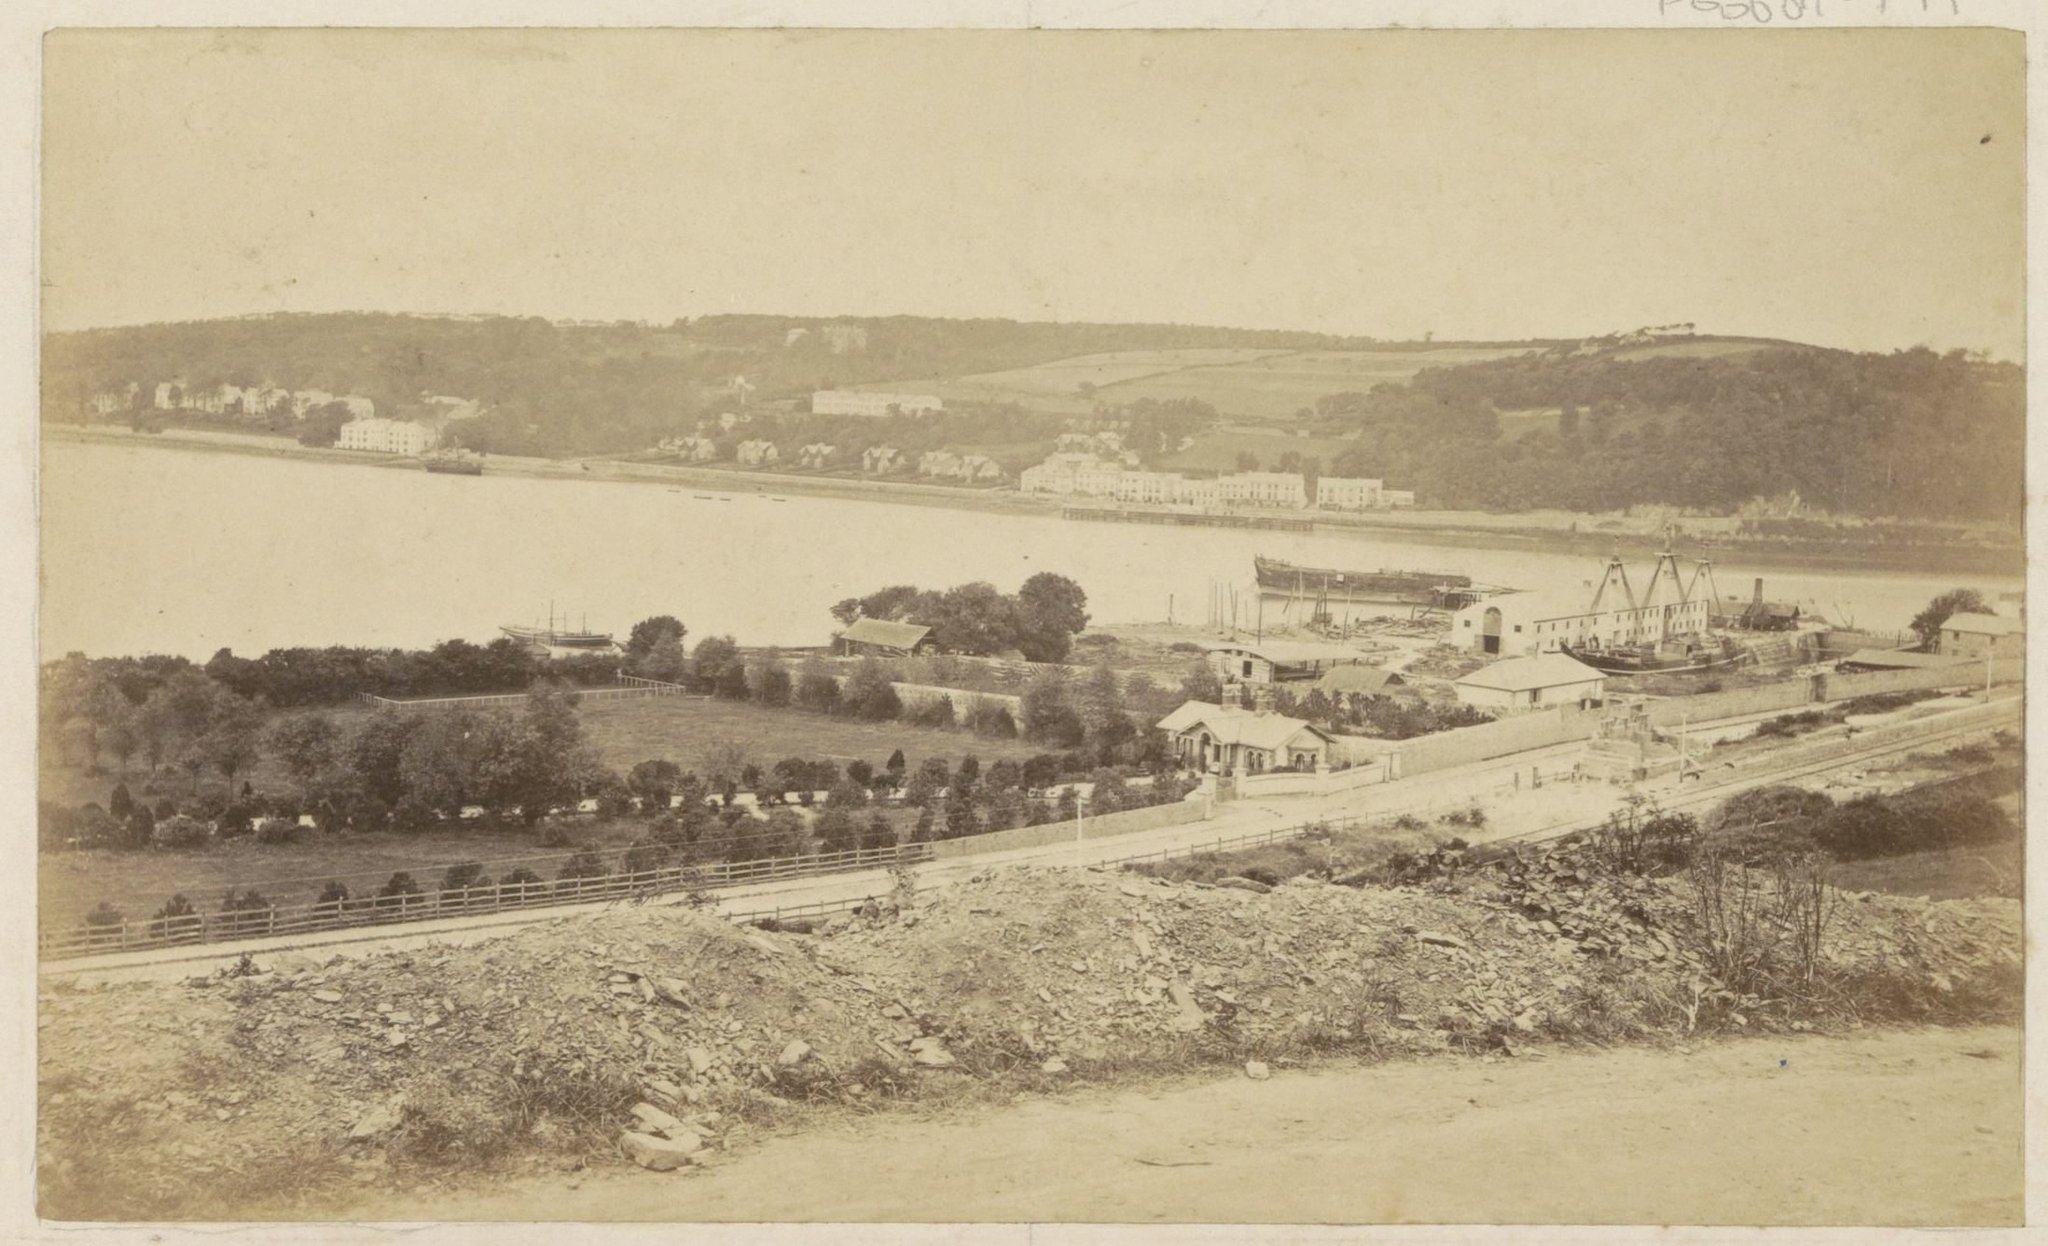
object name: photograph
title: Gezicht op een haven aan de kust, vermoedelijk in Engeland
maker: Anonymous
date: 1850-1870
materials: paper, photographic support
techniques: albumen print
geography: england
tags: harbour (+ view ~ vehicle, ship, etc.), england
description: Onderdeel van Album met foto's van bezienswaardigheden en landschappen in Engeland en van kunst.